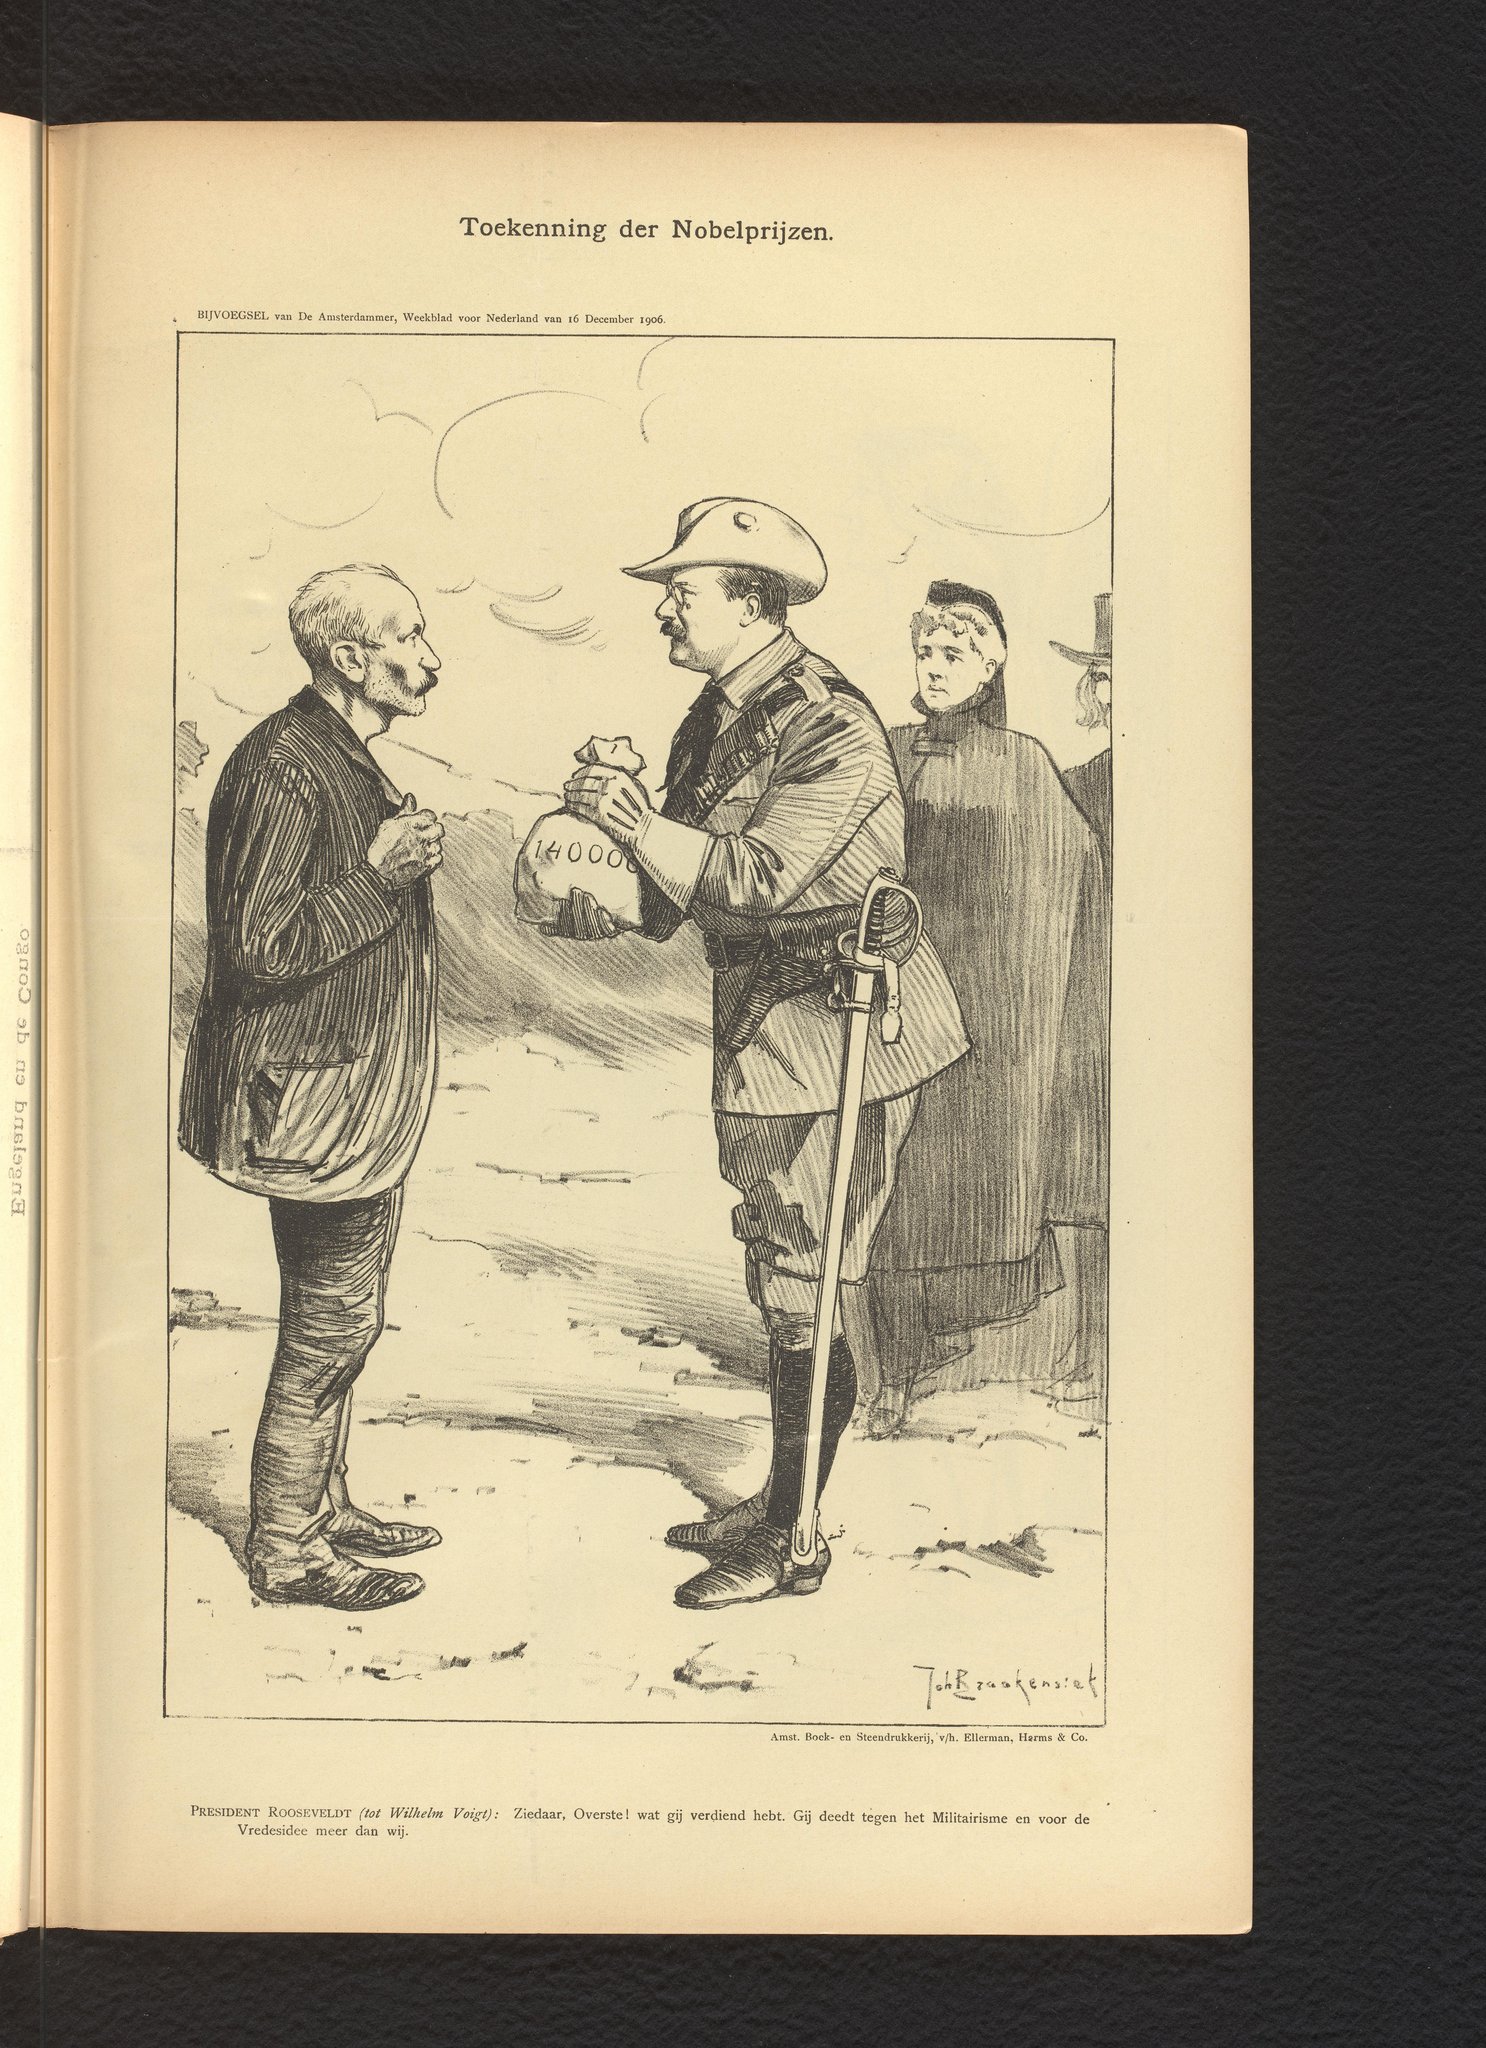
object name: cartoon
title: Toekenning der Nobelprijzen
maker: johan braakensiek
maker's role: draughtsman, print maker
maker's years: 1858-1940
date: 1906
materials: paper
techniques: lithograph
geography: amsterdam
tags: new york (city), anti-militarism, pacifism, political caricatures and satires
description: De Amerikaanse president Theodore Roosevelt, winnaar van de Nobelprijs voor de Vrede in 1906, beloont de arme schoenmaker Wilhelm Voigt, de zogenaamde Hauptmann von Köpenick, met een zak geld. De pacifiste Bertha von Suttner kijkt toe.